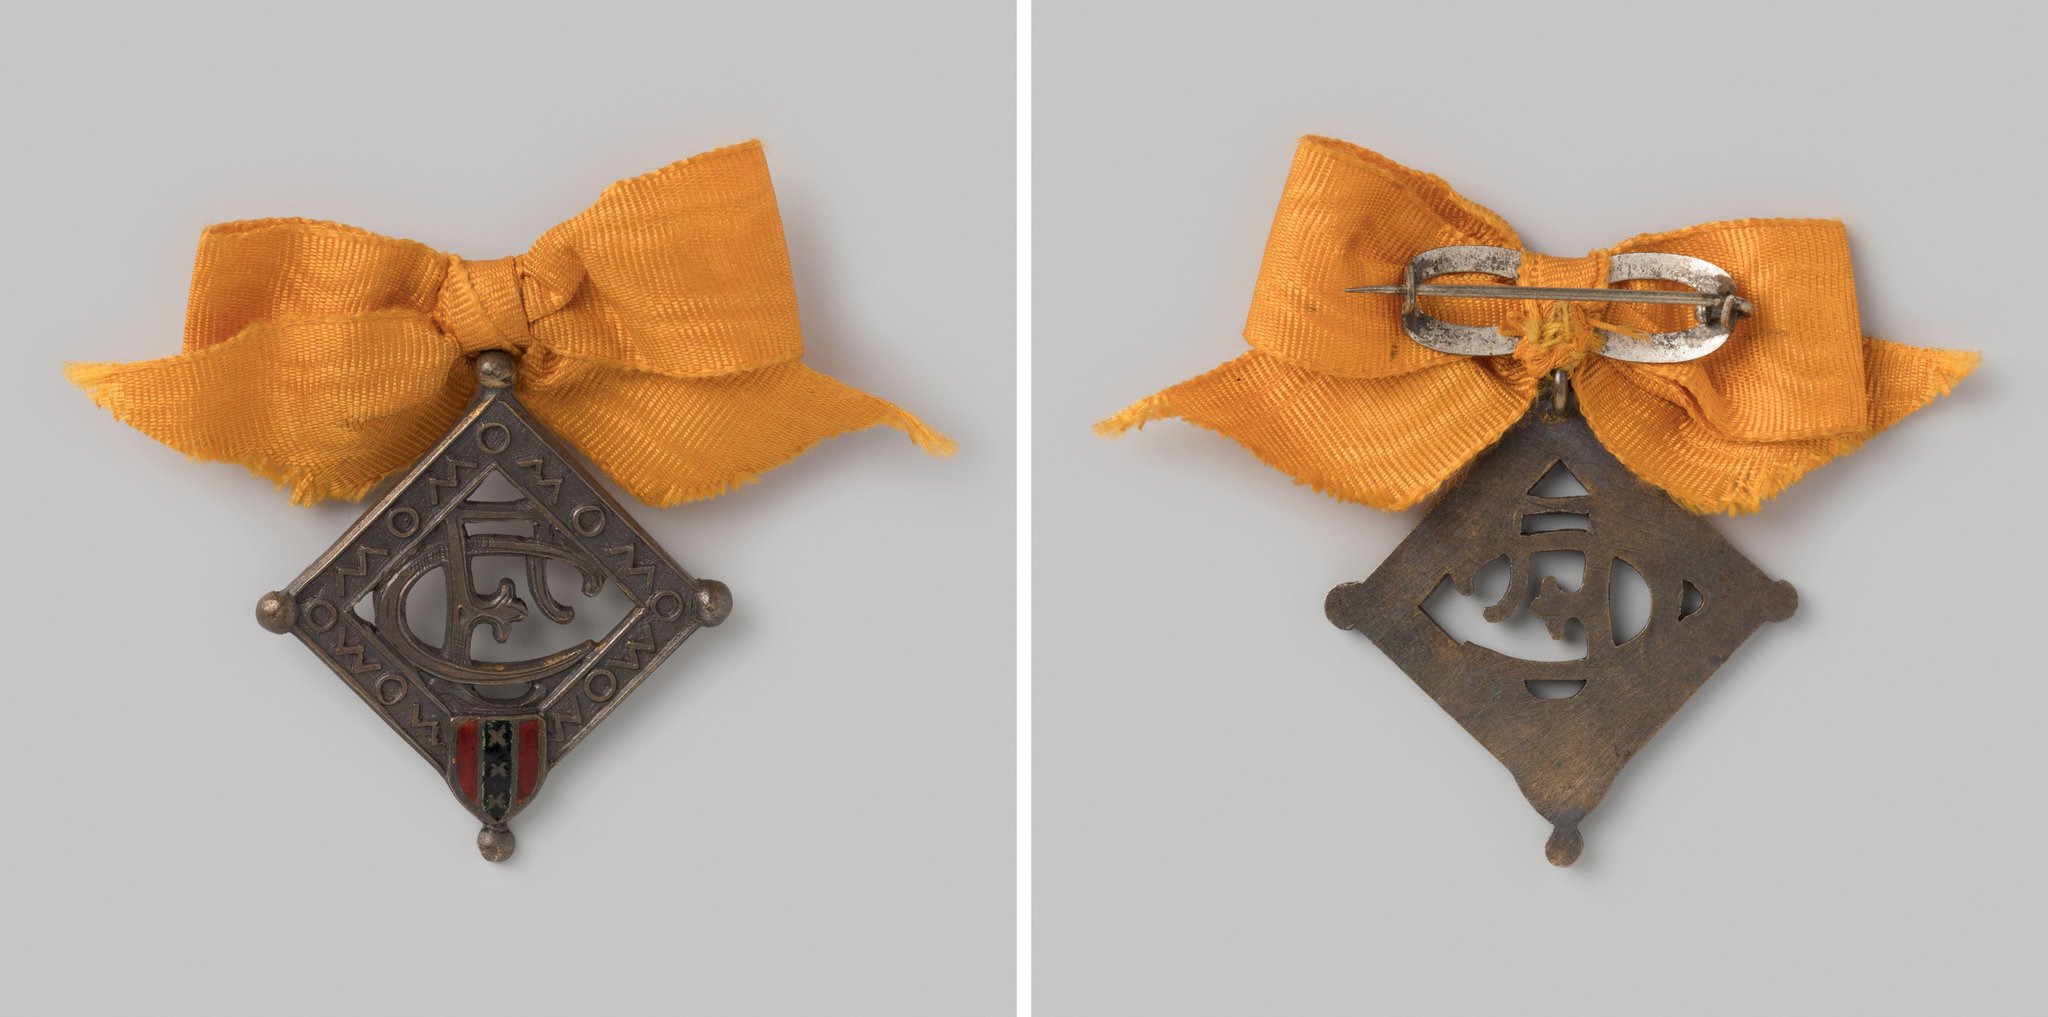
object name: history medal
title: Draagteken voor de feestcommissie te Amsterdam bij het huwelijk van Koningin Wilhelmina 1901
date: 1901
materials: silver, textile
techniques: pressing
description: Ruitvormig zilveren draagteken aan broche met oranje strik, opengewerkt tot de letters FC, de rand bezet met de letters O en M en onderaan een geëmaileerd Amsterdams wapenschildje.